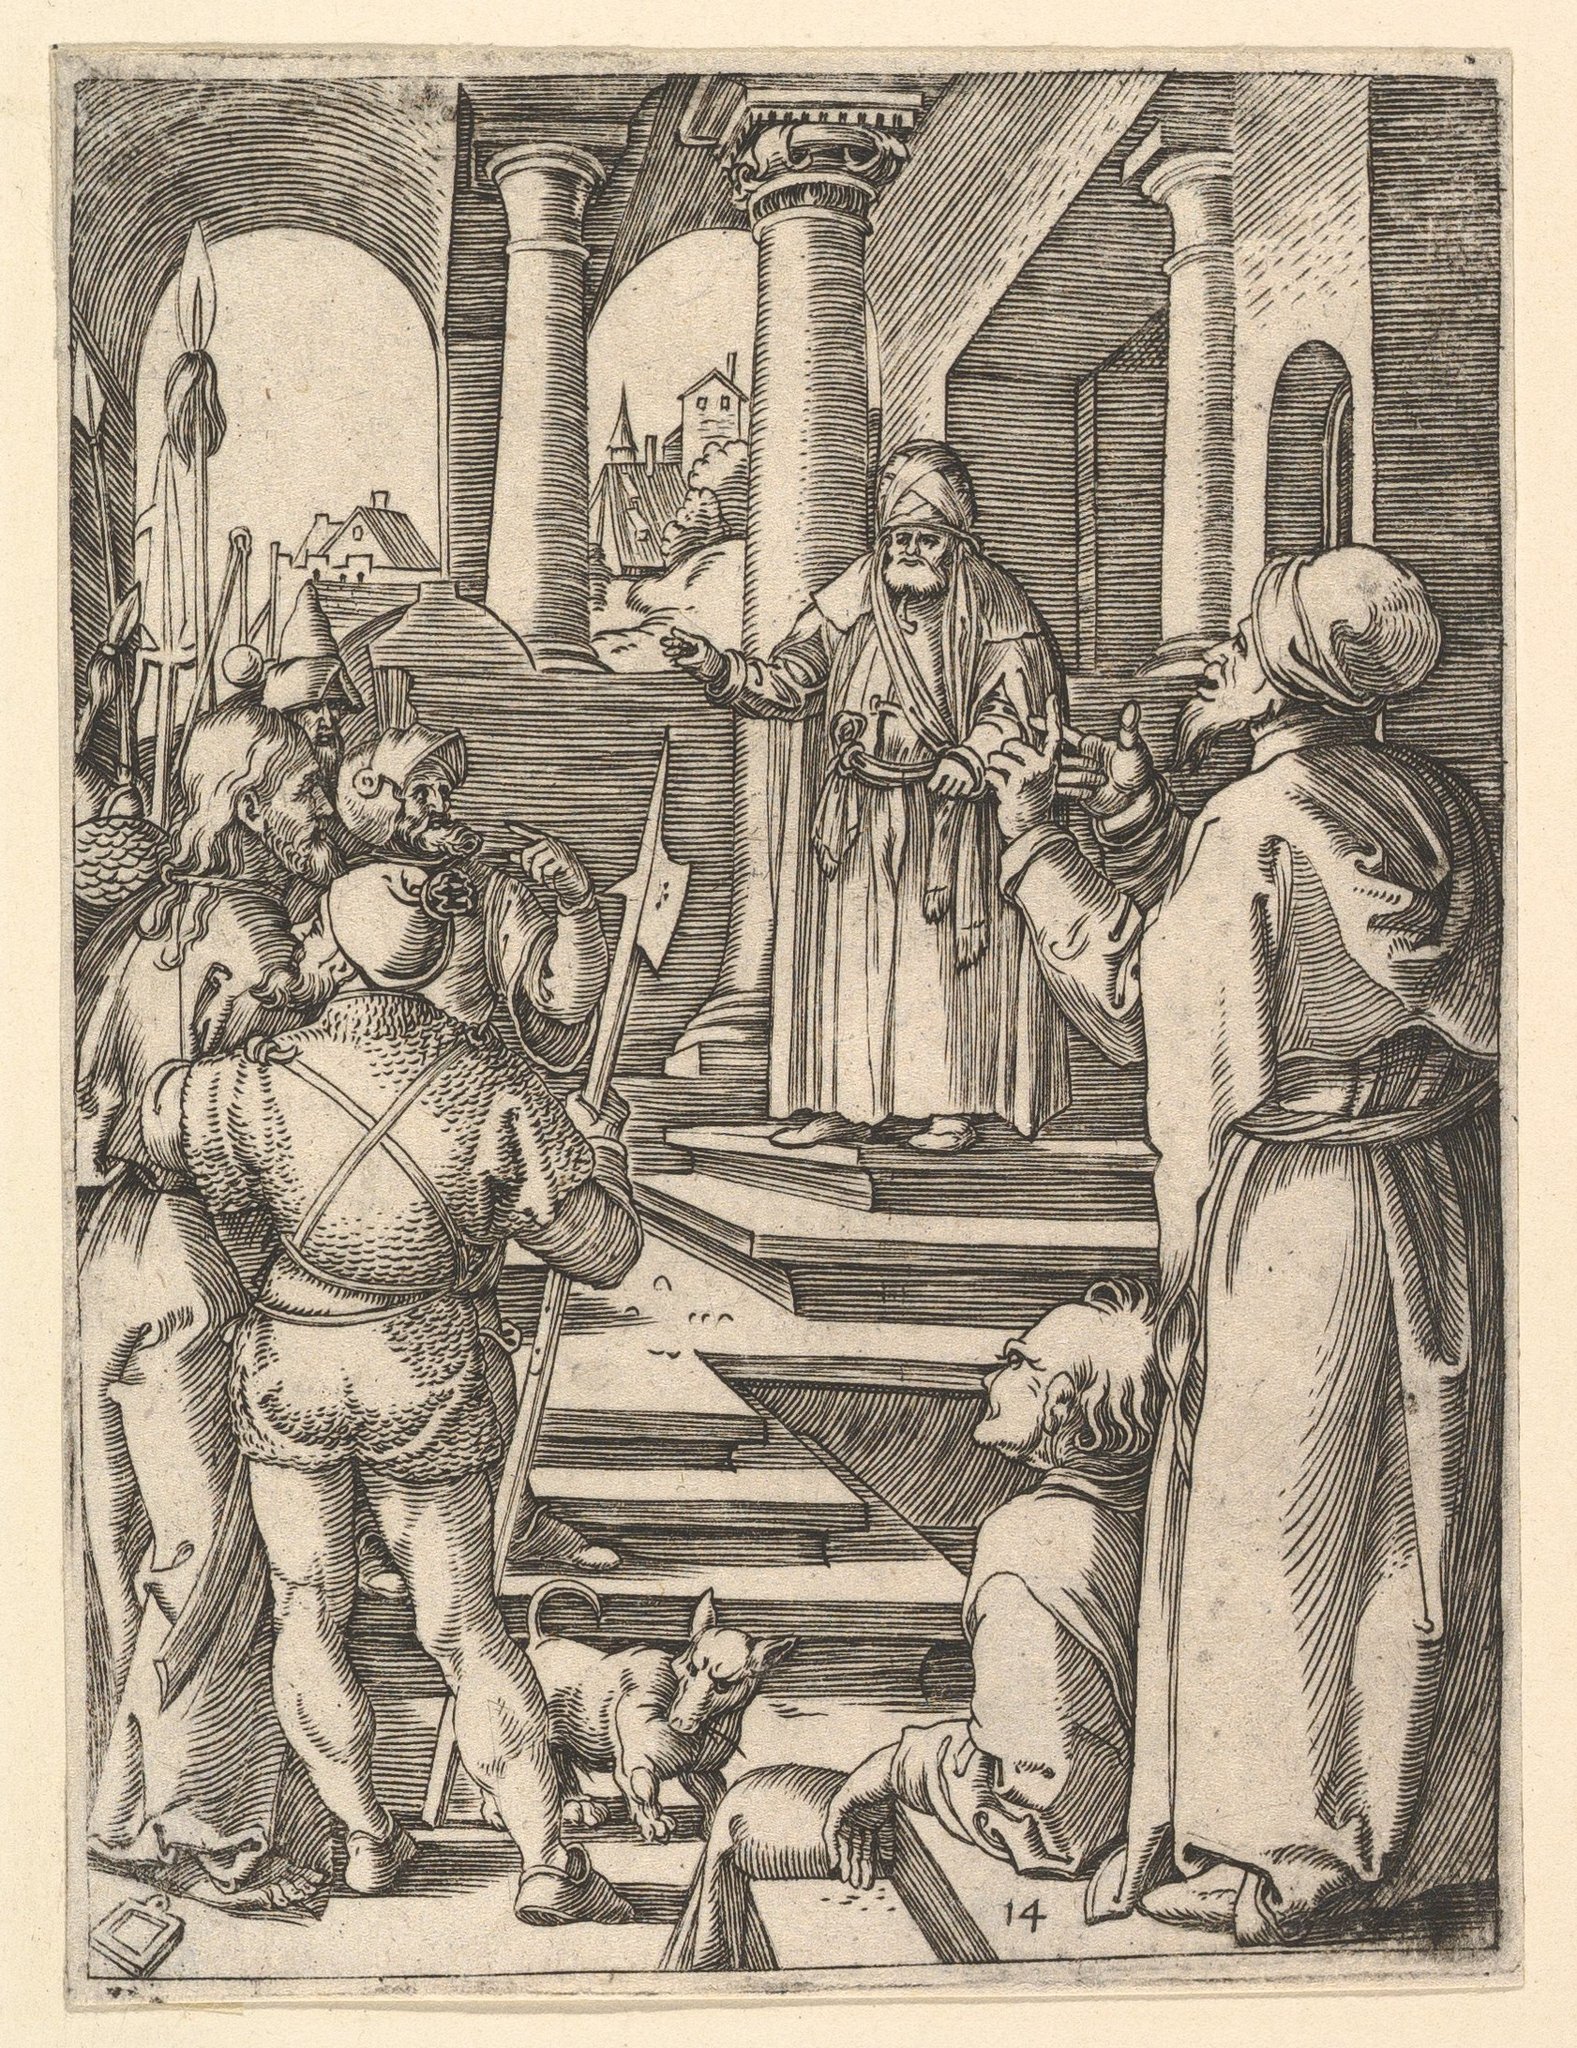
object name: print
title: Christ presented to Pilate by henchmen, from "The Passion of Christ", after Dürer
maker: marcantonio raimondi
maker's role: artist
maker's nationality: italian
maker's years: 1475-1534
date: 1500-1534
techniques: engraving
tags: men,christ,pilate